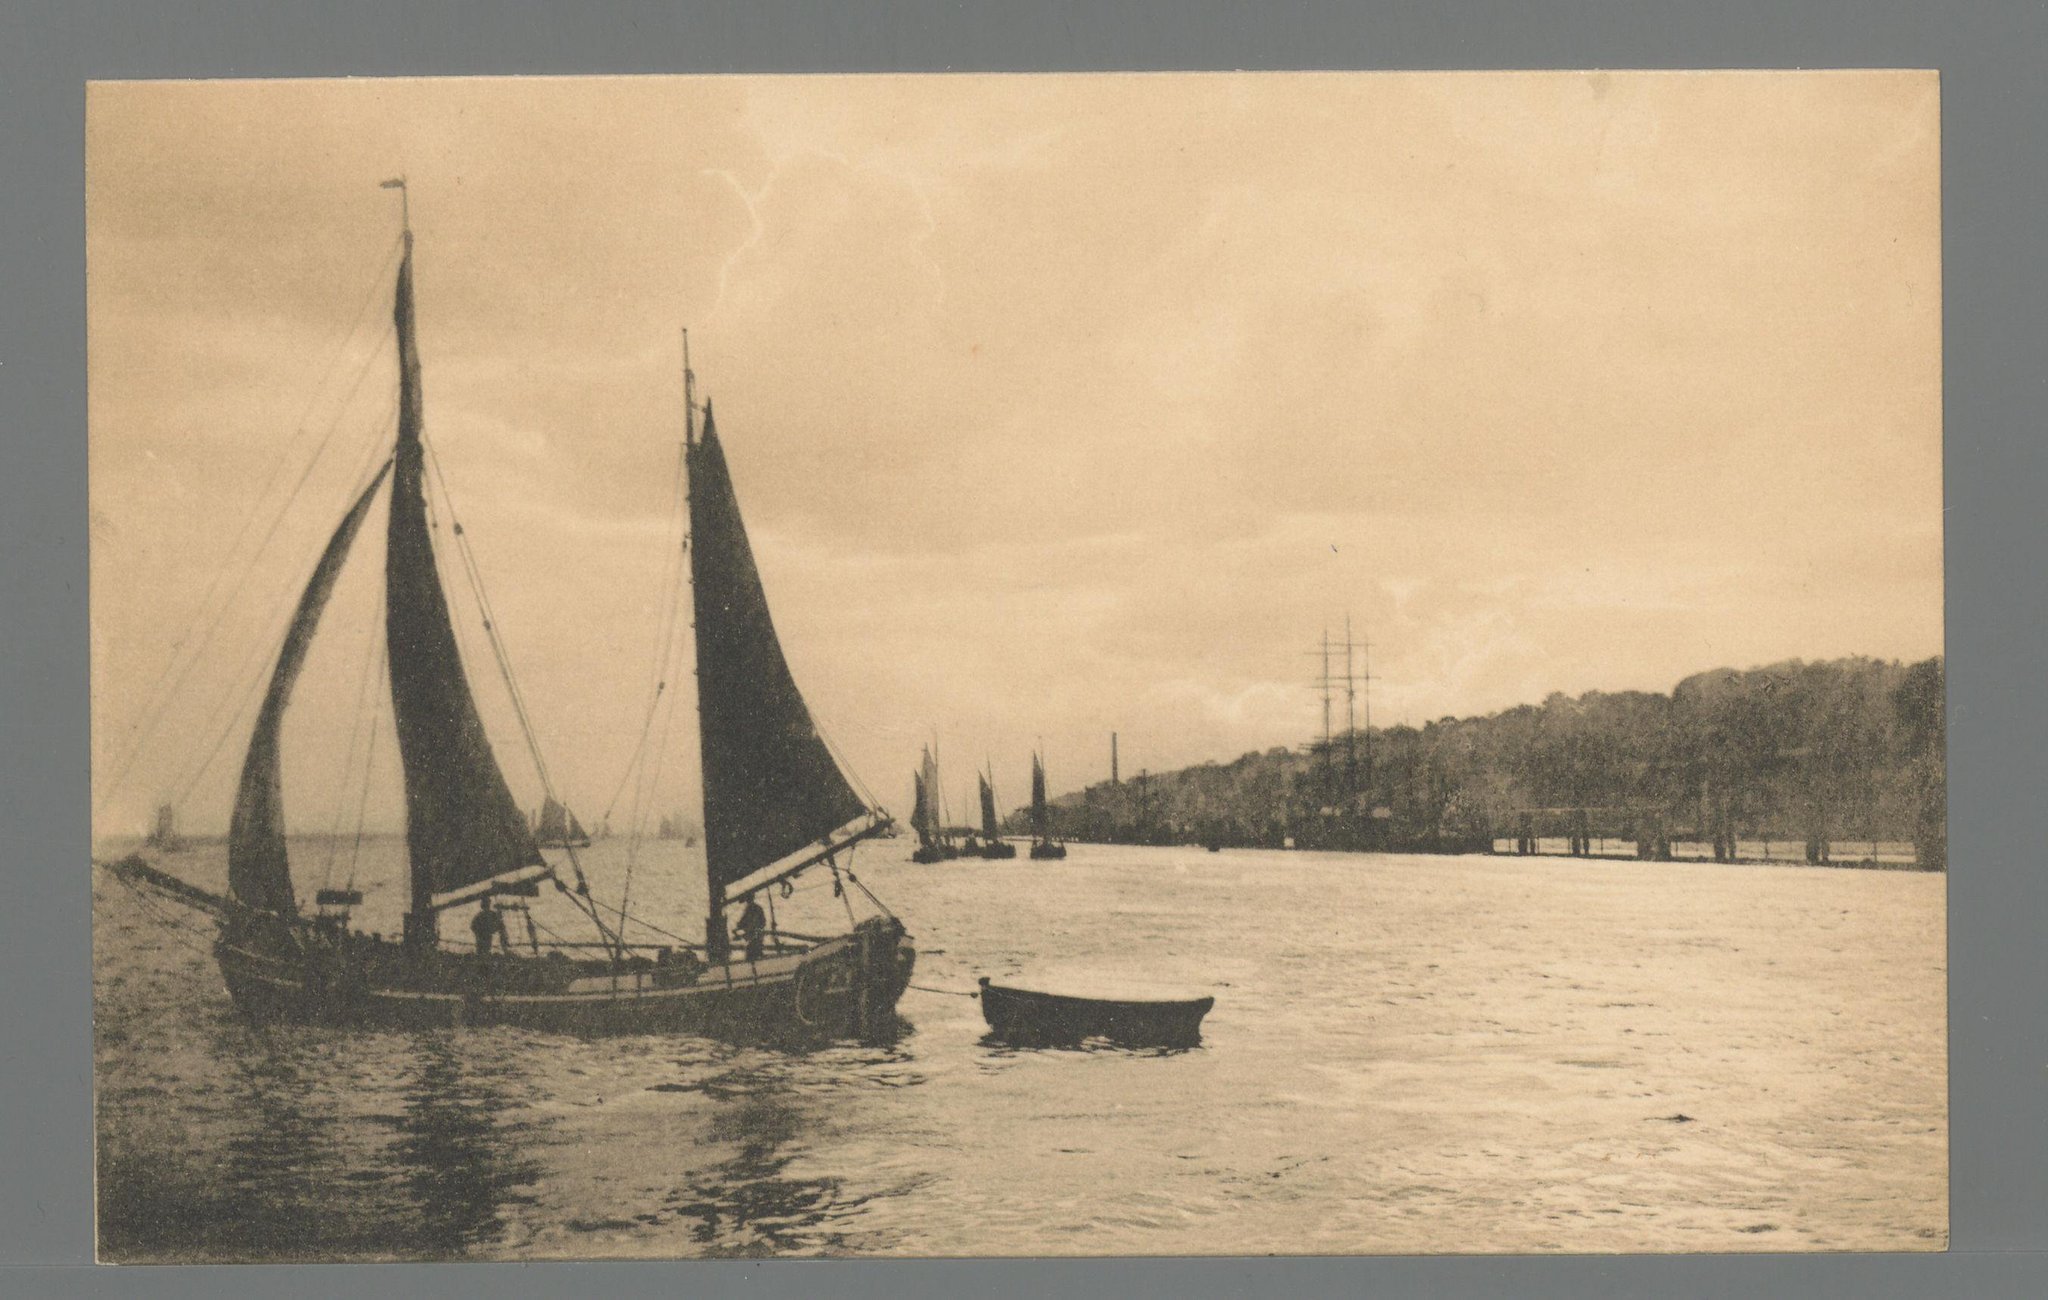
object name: ansichtkaart, prentbriefkaart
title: Luxusdruck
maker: willy wilcke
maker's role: fotograaf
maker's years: 1864-1945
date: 1904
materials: cardboard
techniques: photograph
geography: hamburg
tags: harbour, sailing-ship, sailing-boat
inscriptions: date